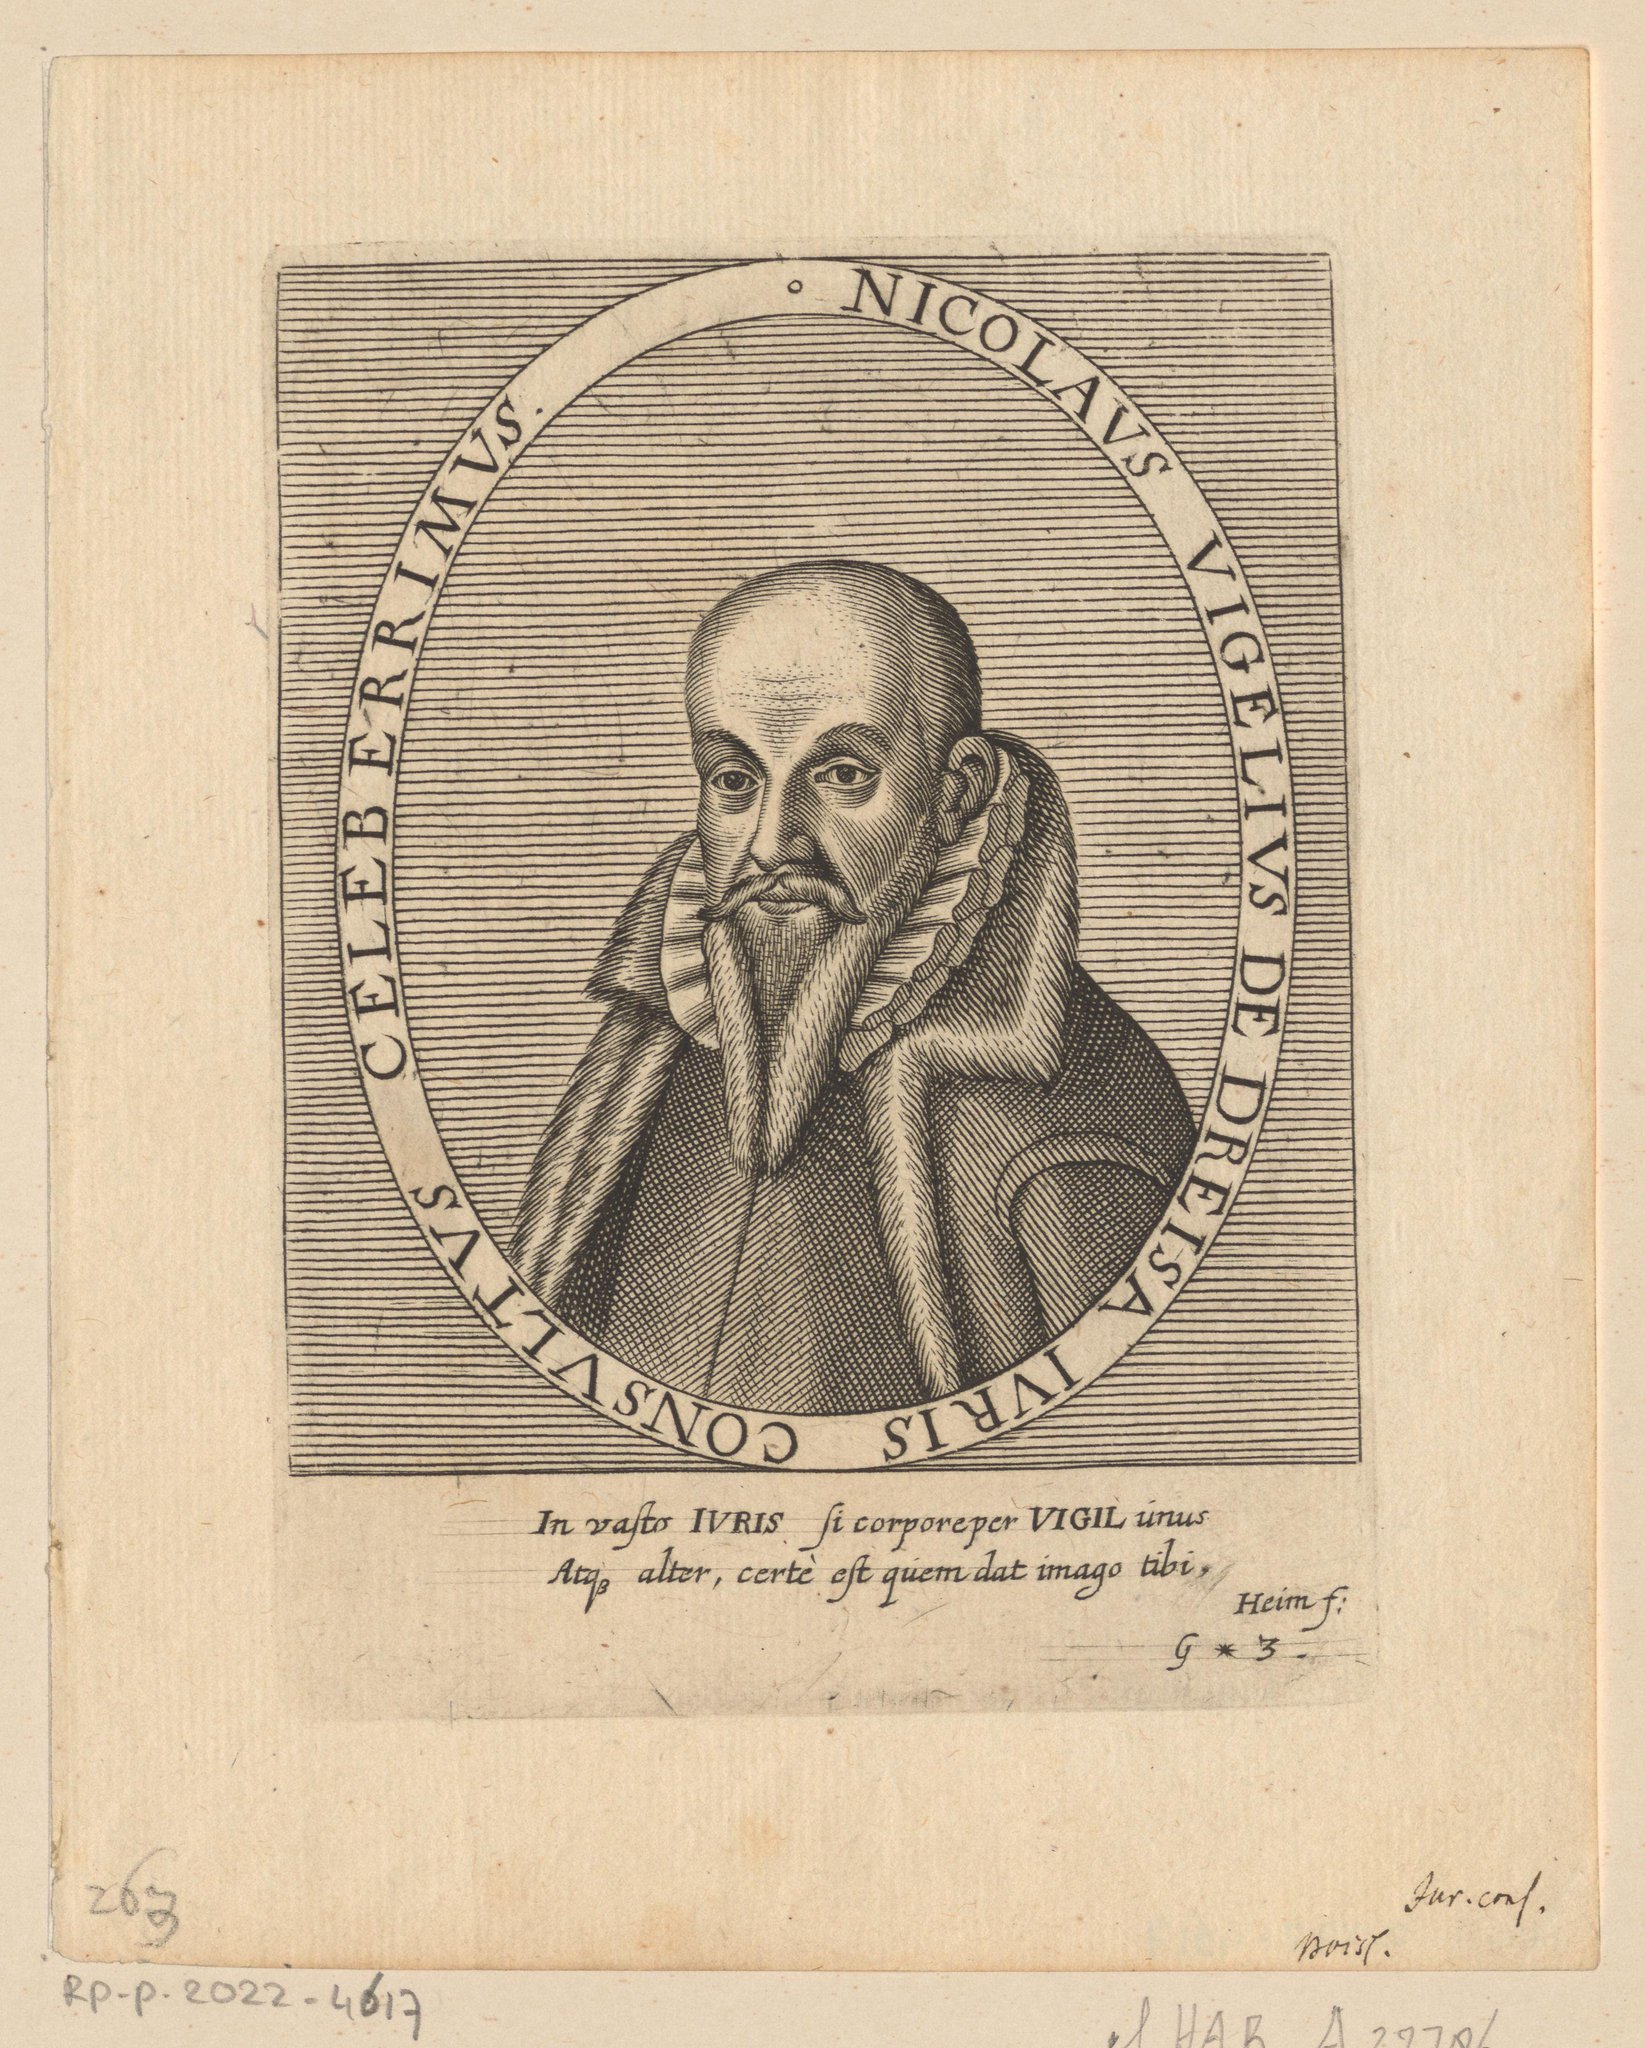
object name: print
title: Portretten van geleerden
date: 1643-1654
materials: paper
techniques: engraving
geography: germany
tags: historical persons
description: Latere staat gebruikt in: Boissard, Jean Jacques. Bibliotheca chalcographica (...) Frankfurt am Main: Johannes Ammon, 1654, dl. 9.